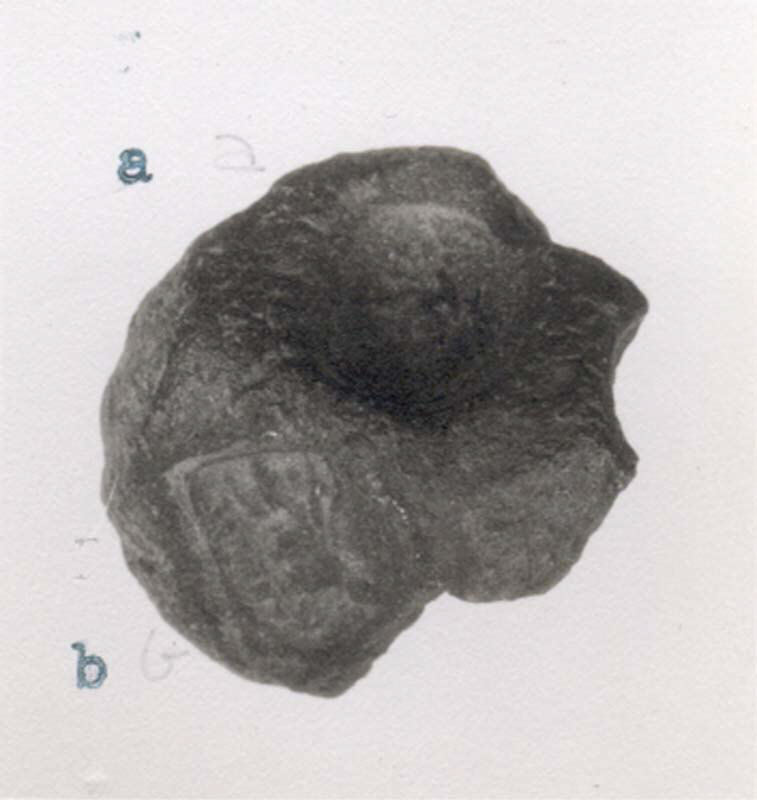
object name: sealing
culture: sasanian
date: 601-700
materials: clay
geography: iran